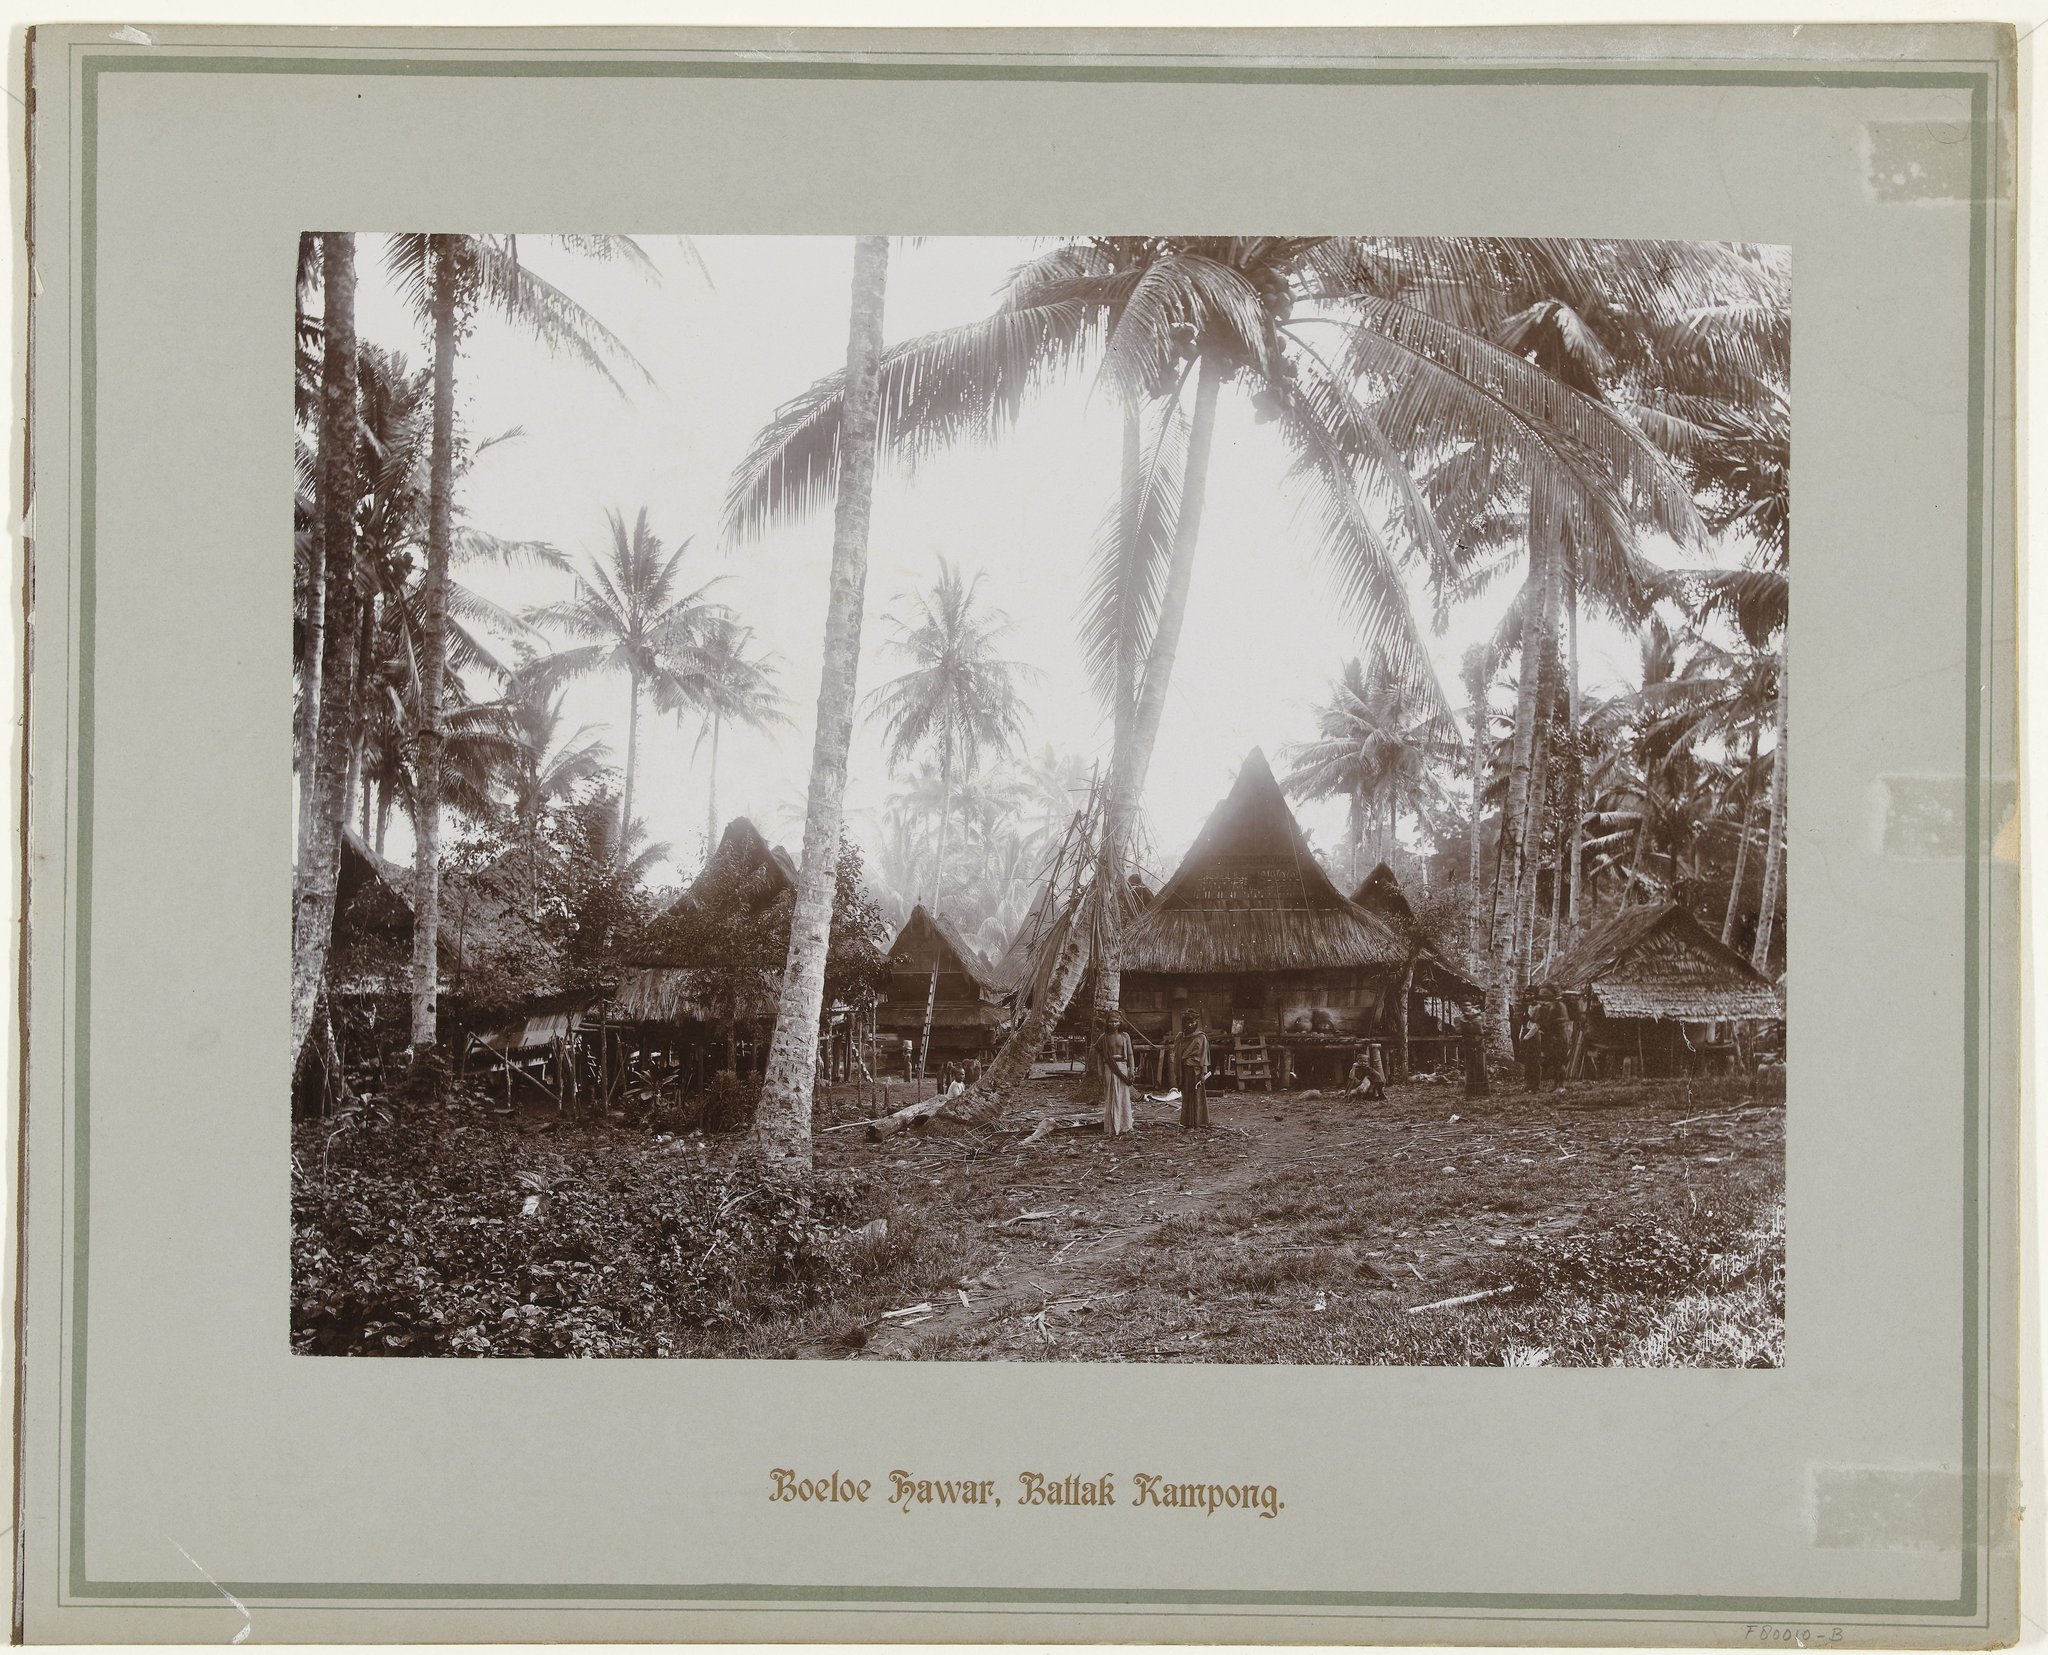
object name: photograph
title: Boeloe Hawar, Battak Kampong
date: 1890-1900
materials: cardboard, paper, photographic support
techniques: collodion silver print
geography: medan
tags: human races, peoples and nationalities (other than prehistoric or extinct), sumatra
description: Boeloe Hawar, Battak Kampong op Sumatra. Foto geplakt op losgesneden blad uit album, op verso bevindt zich nog een foto uit dezelfde serie